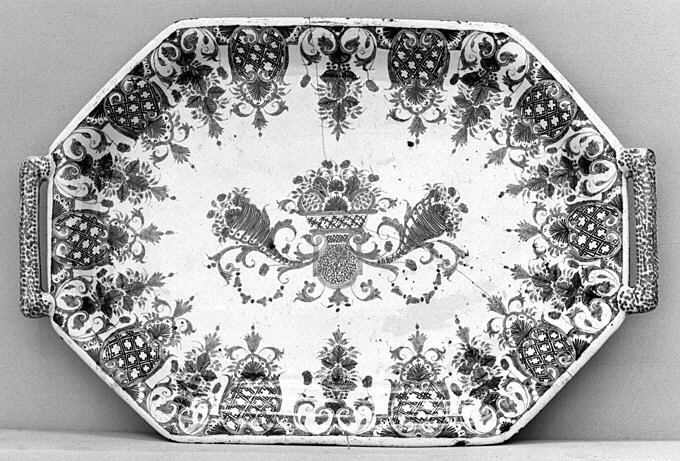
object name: plateau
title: Plateau (Banette)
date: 1705-1720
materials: faience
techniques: glazing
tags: flowers